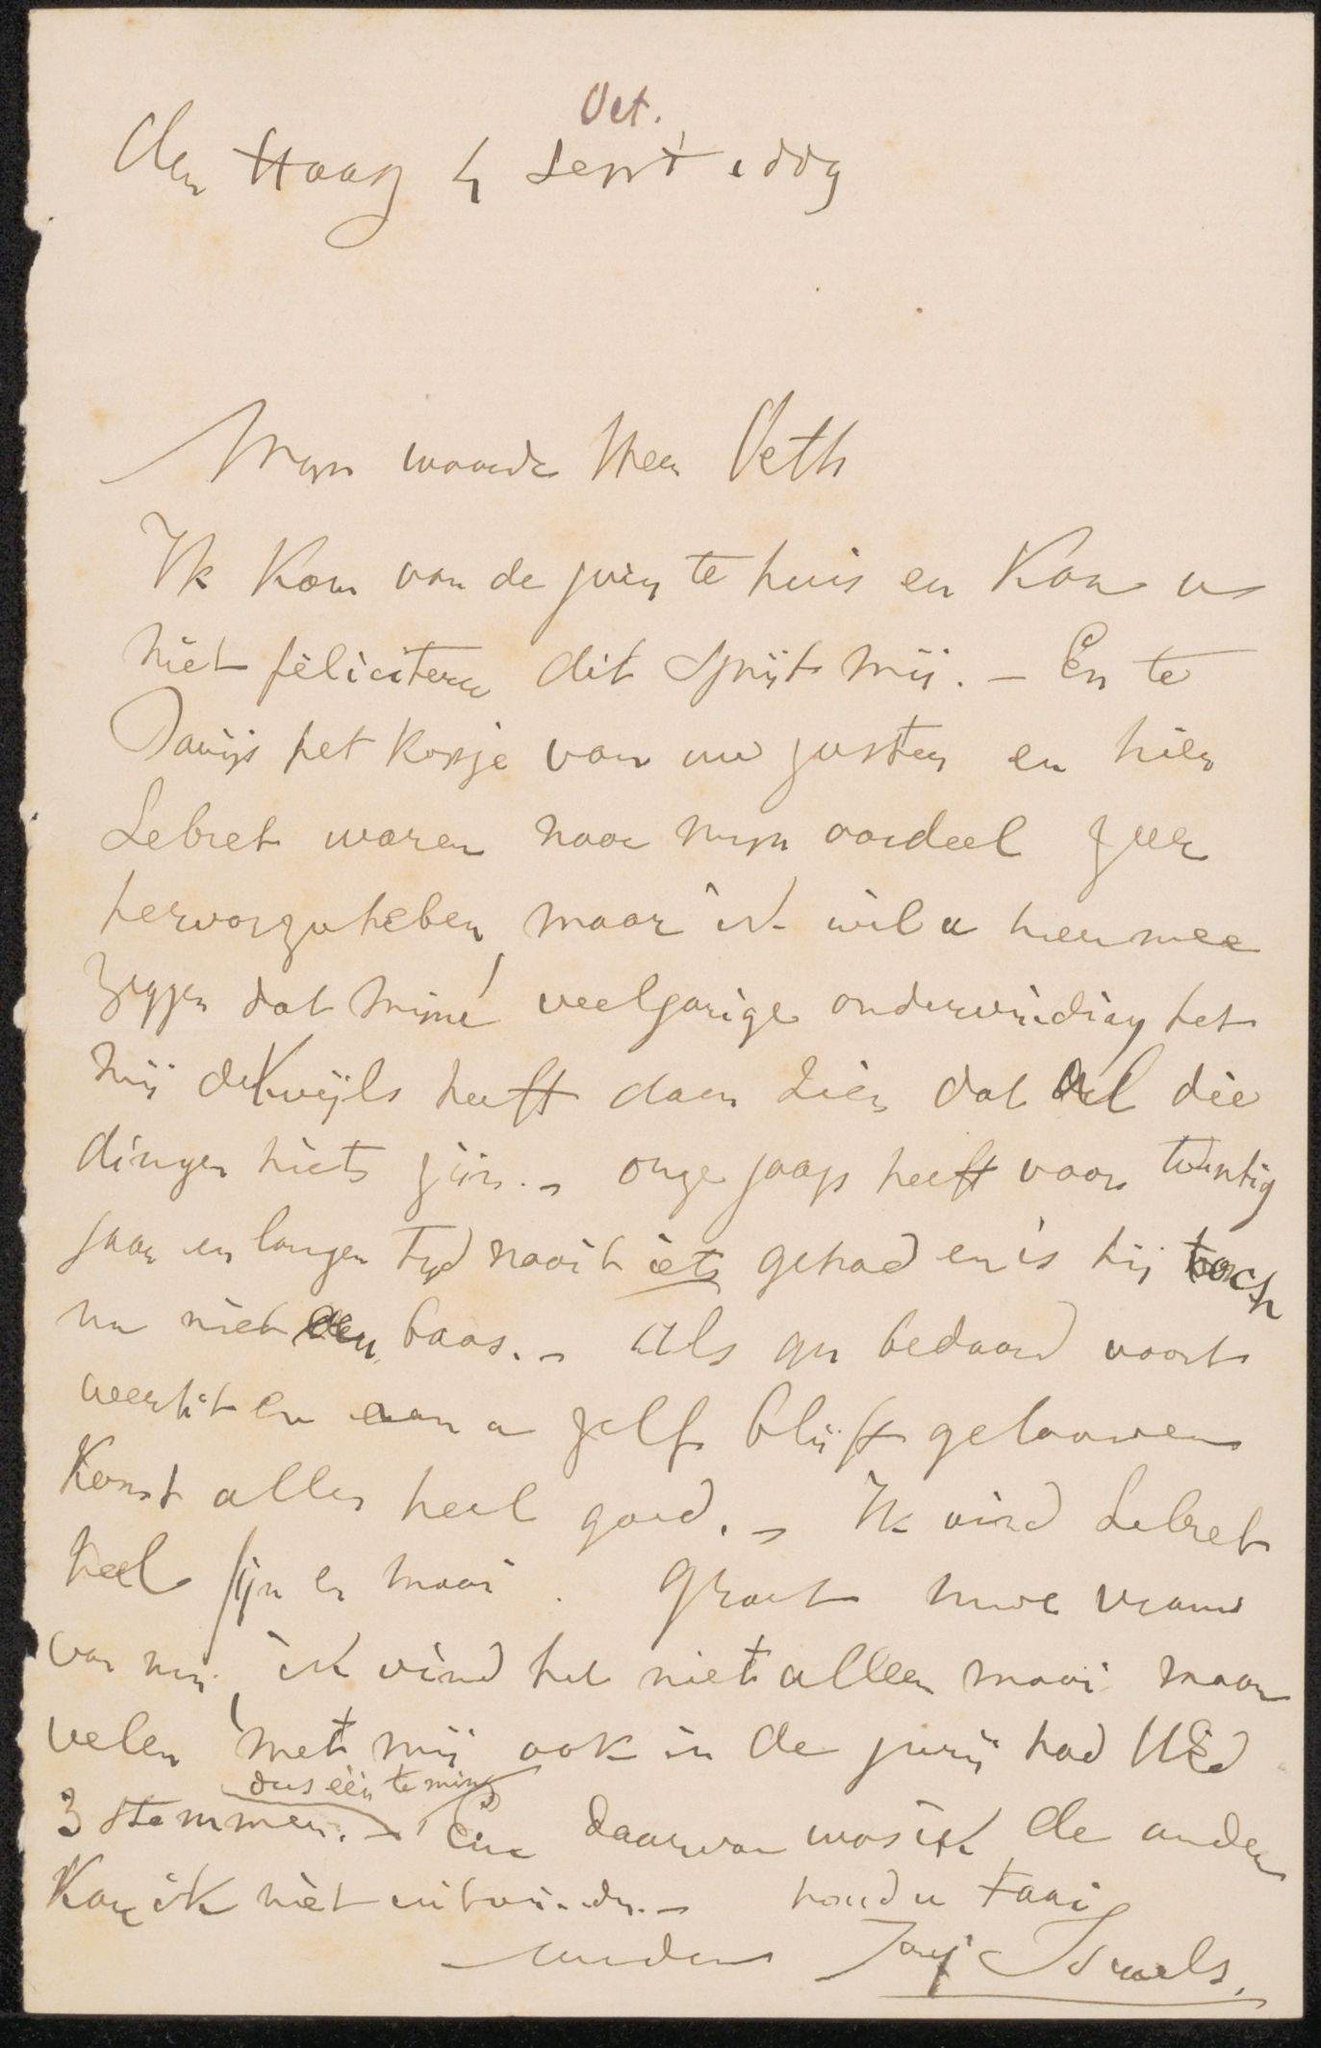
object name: letter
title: Brief aan Jan Veth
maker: jozef israëls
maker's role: draughtsman, painter, print maker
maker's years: 1824-1911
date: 1889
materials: ink, paper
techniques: pen, writing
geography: the hague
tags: jan veth, painter, print maker, draughtsman, frans lebret, jacob maris, paris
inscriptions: collector's mark: ‘RPK’